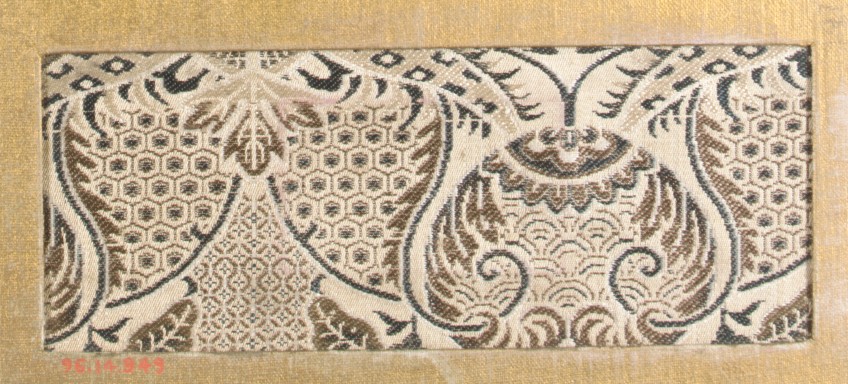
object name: piece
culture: japanese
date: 1701-1900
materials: silk